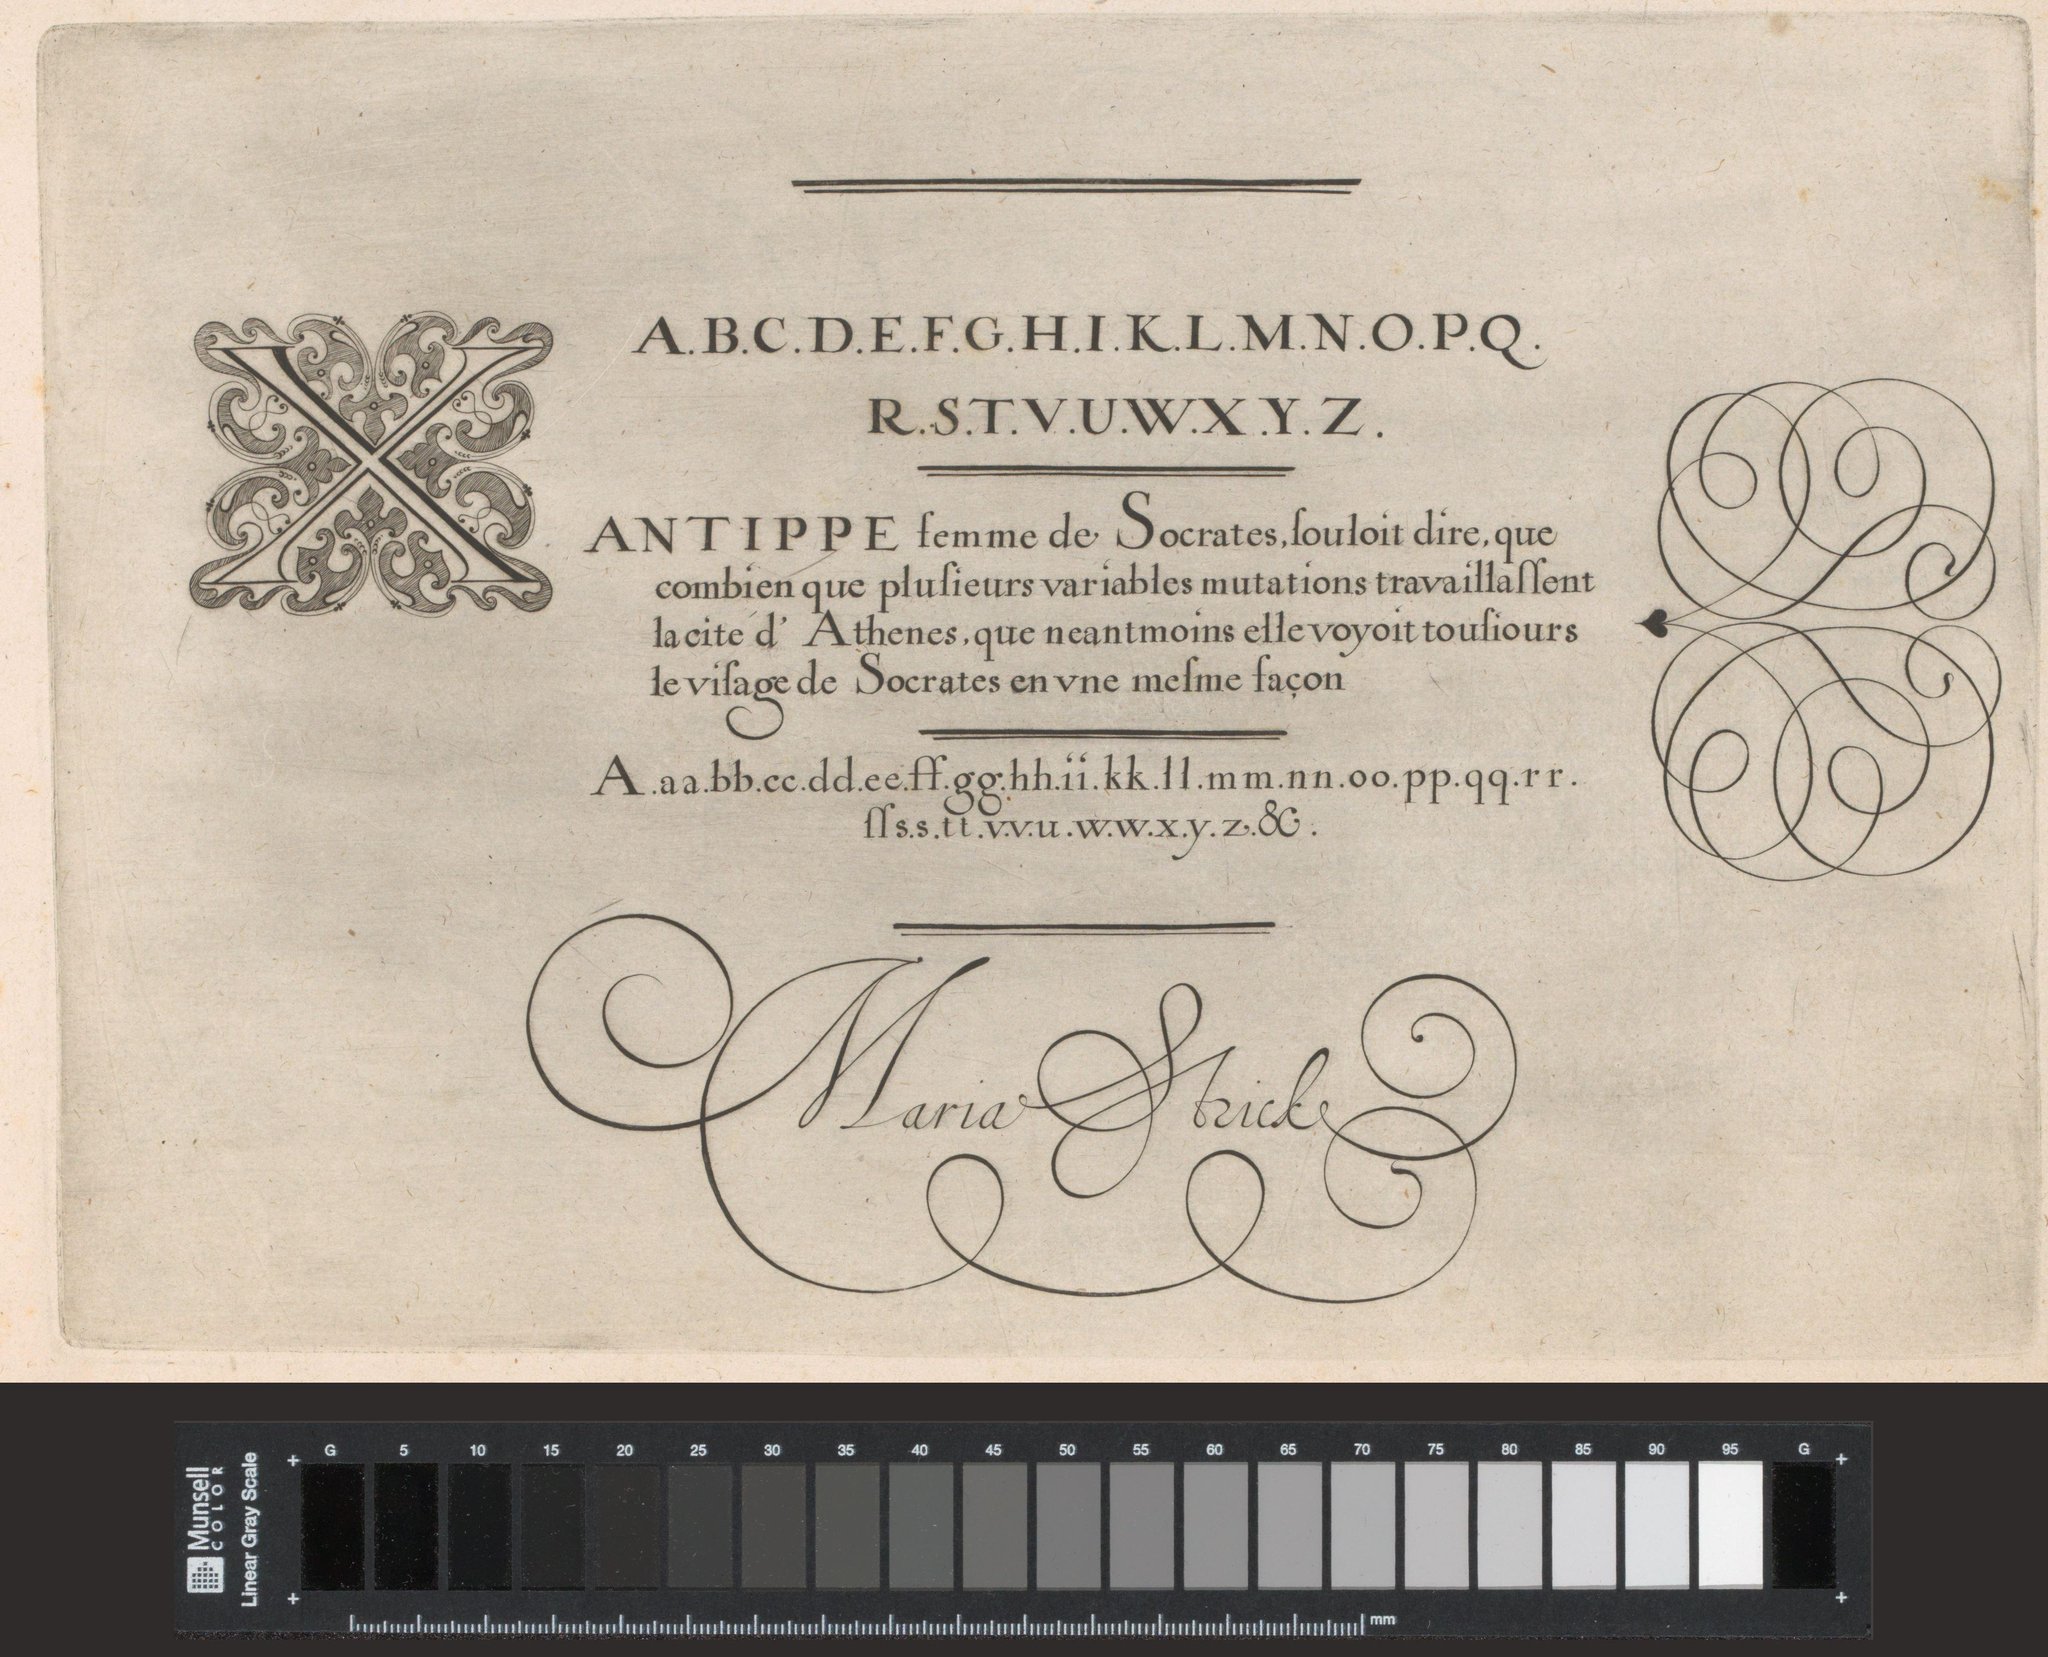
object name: album leaf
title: Schat oft voorbeelt ende verthooninge van verscheyden geschriften (...)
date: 1618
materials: paper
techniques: engraving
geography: rotterdam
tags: calligraphy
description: Schrijfvoorbeeld met kapitaal X en vier regels tekst in het Frans, tussen twee alfabetten: Xantippe femme de Socrates (...). Rechts kalligrafisch krulwerk. De prent maakt deel uit van een album.